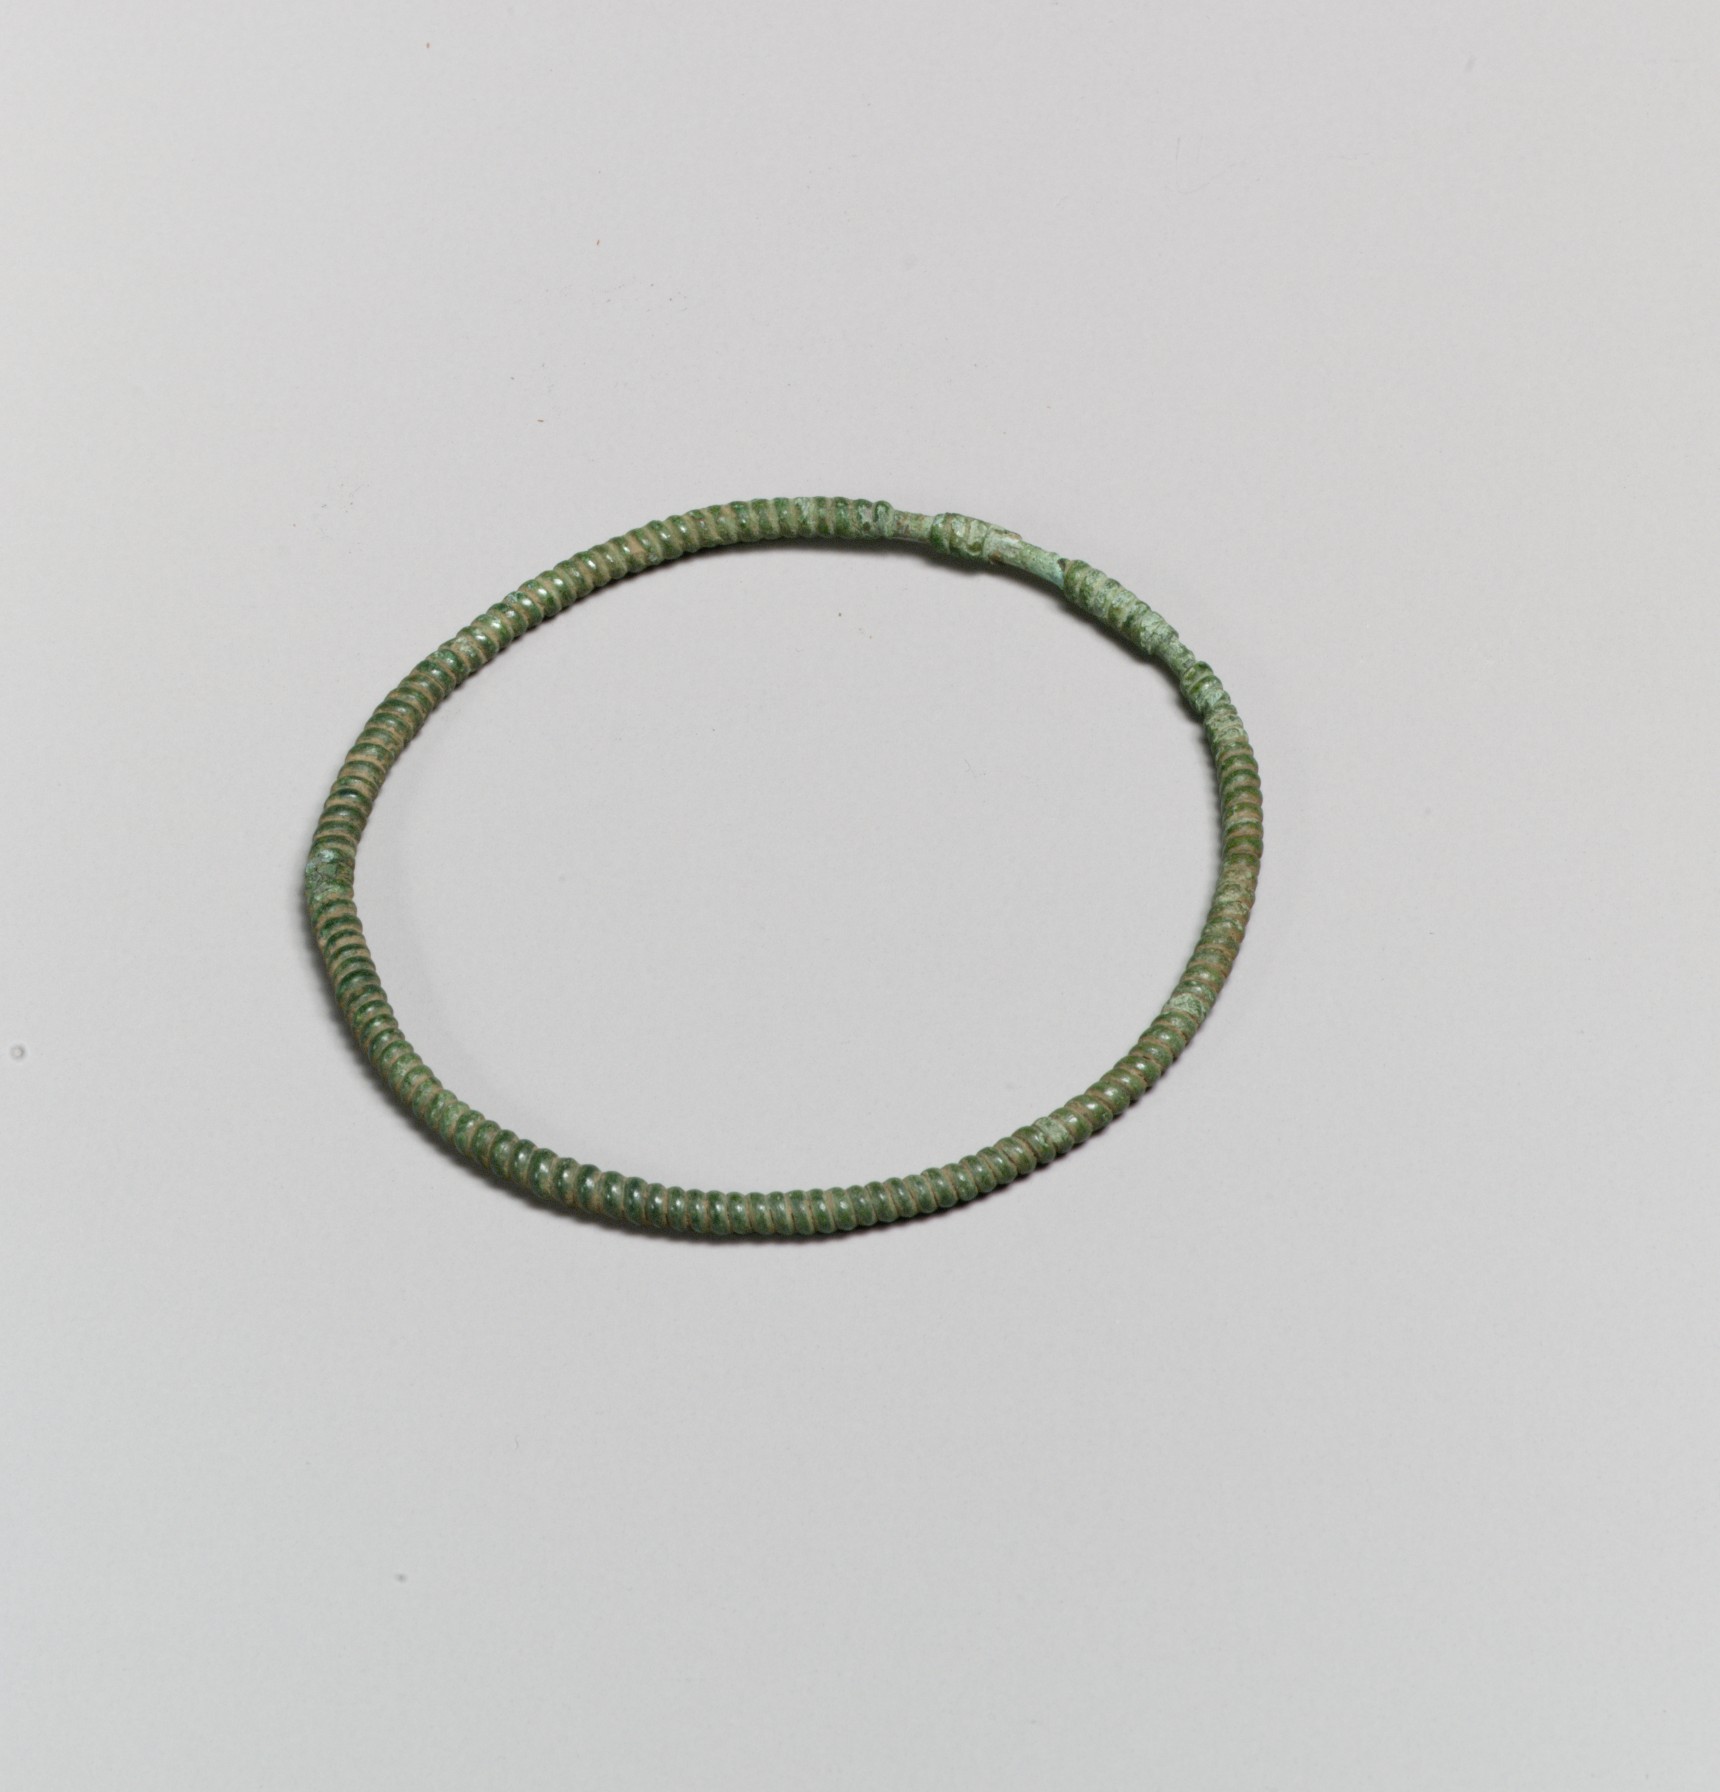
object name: bracelet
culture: roman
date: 1-300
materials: bronze